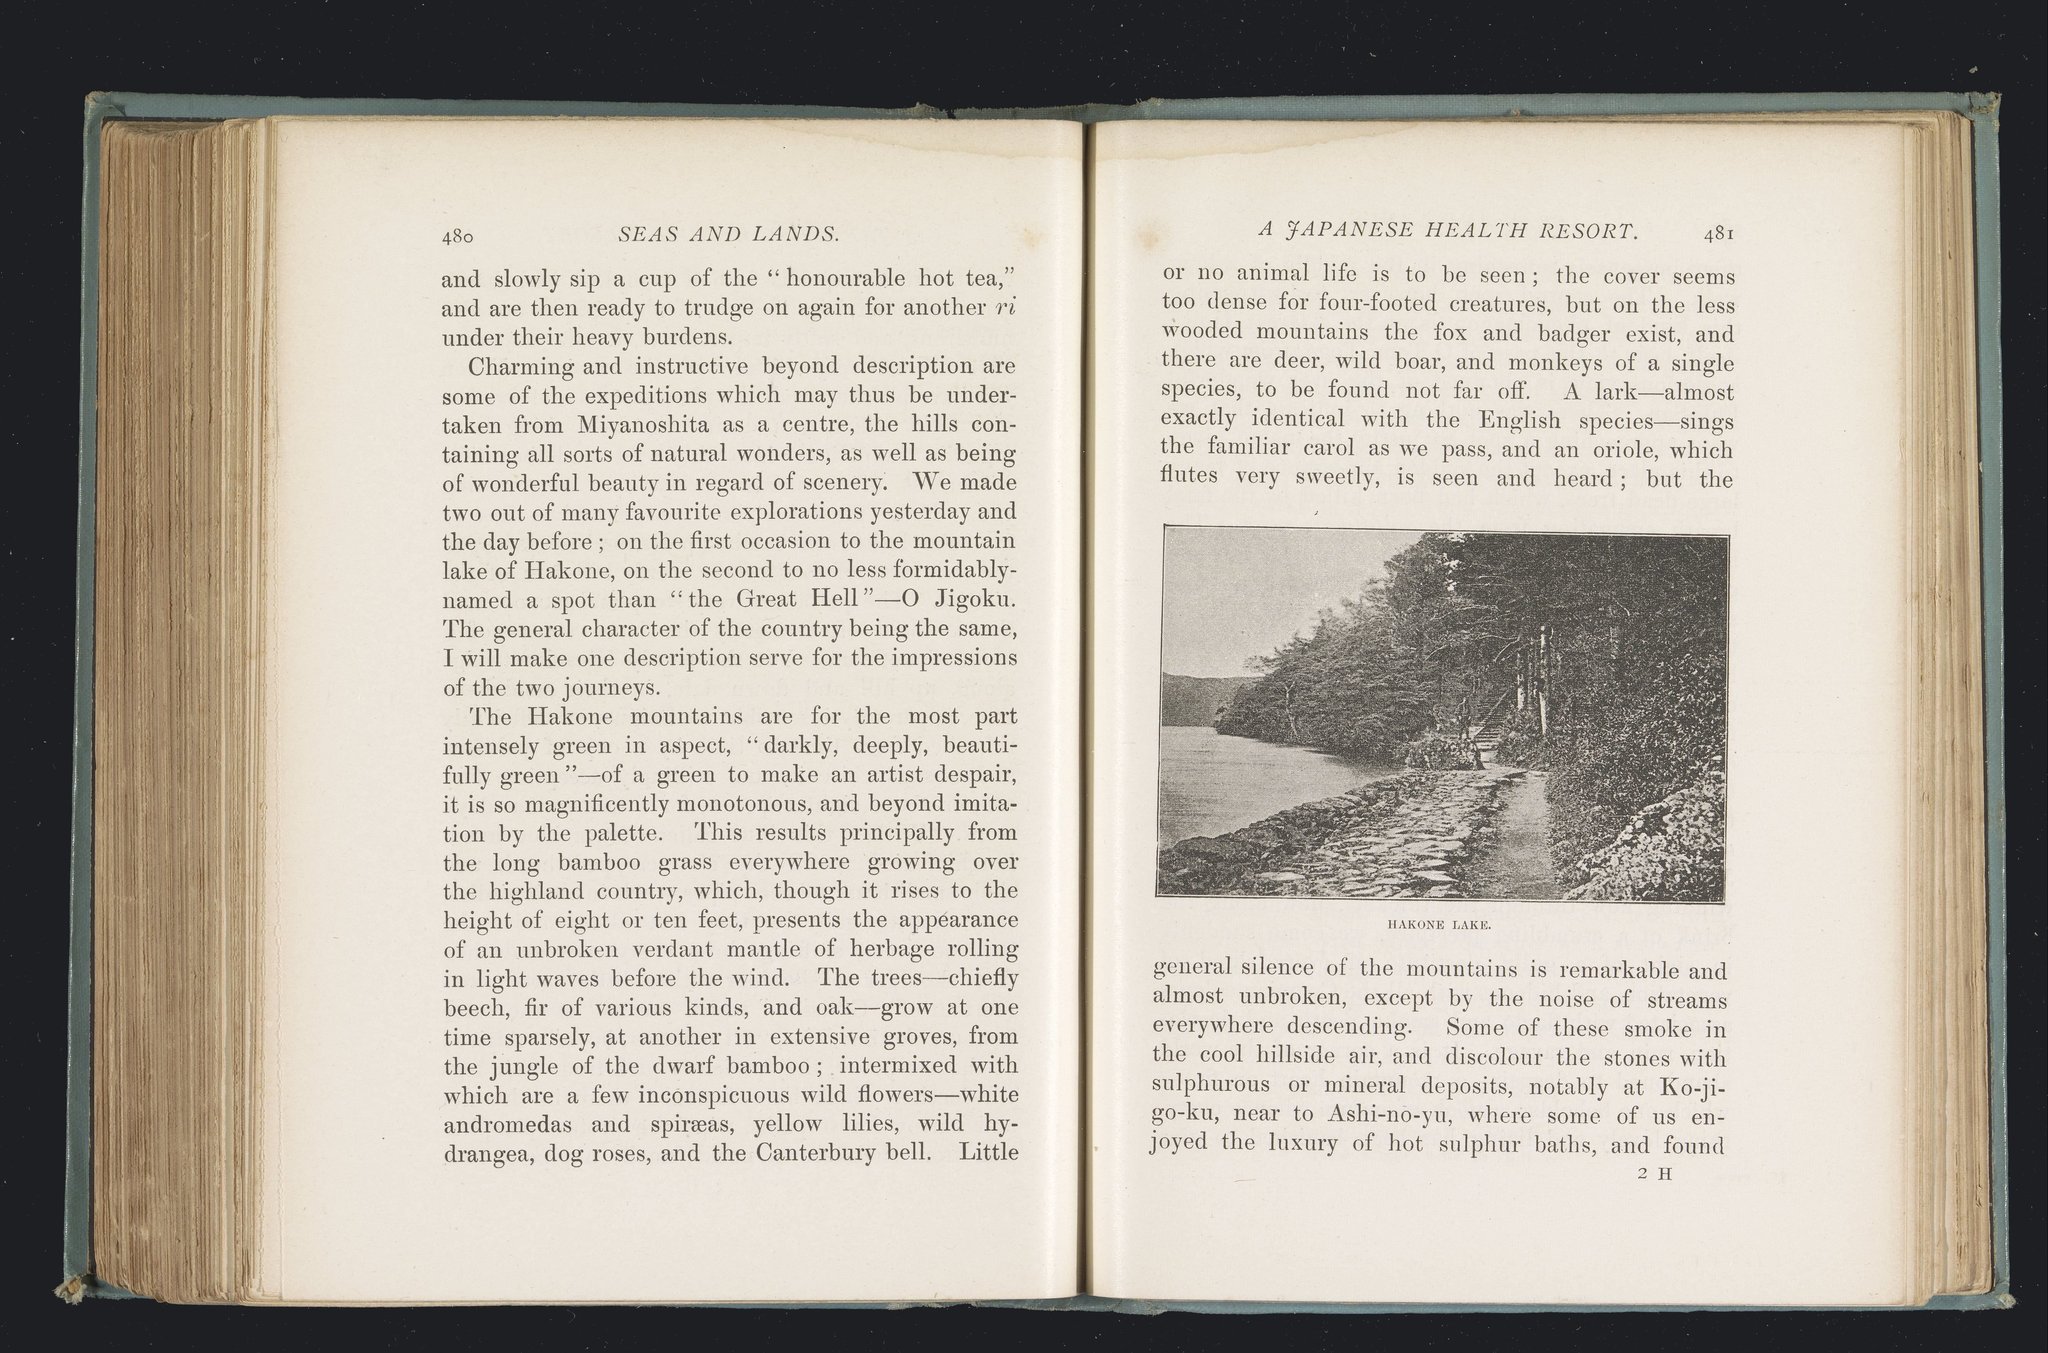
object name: page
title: Hakone lake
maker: Anonymous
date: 1882-1892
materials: paper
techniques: autotype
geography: japan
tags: lake, japan